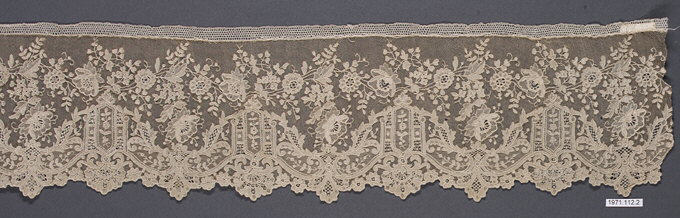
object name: border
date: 1850-1859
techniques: lace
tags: flowers